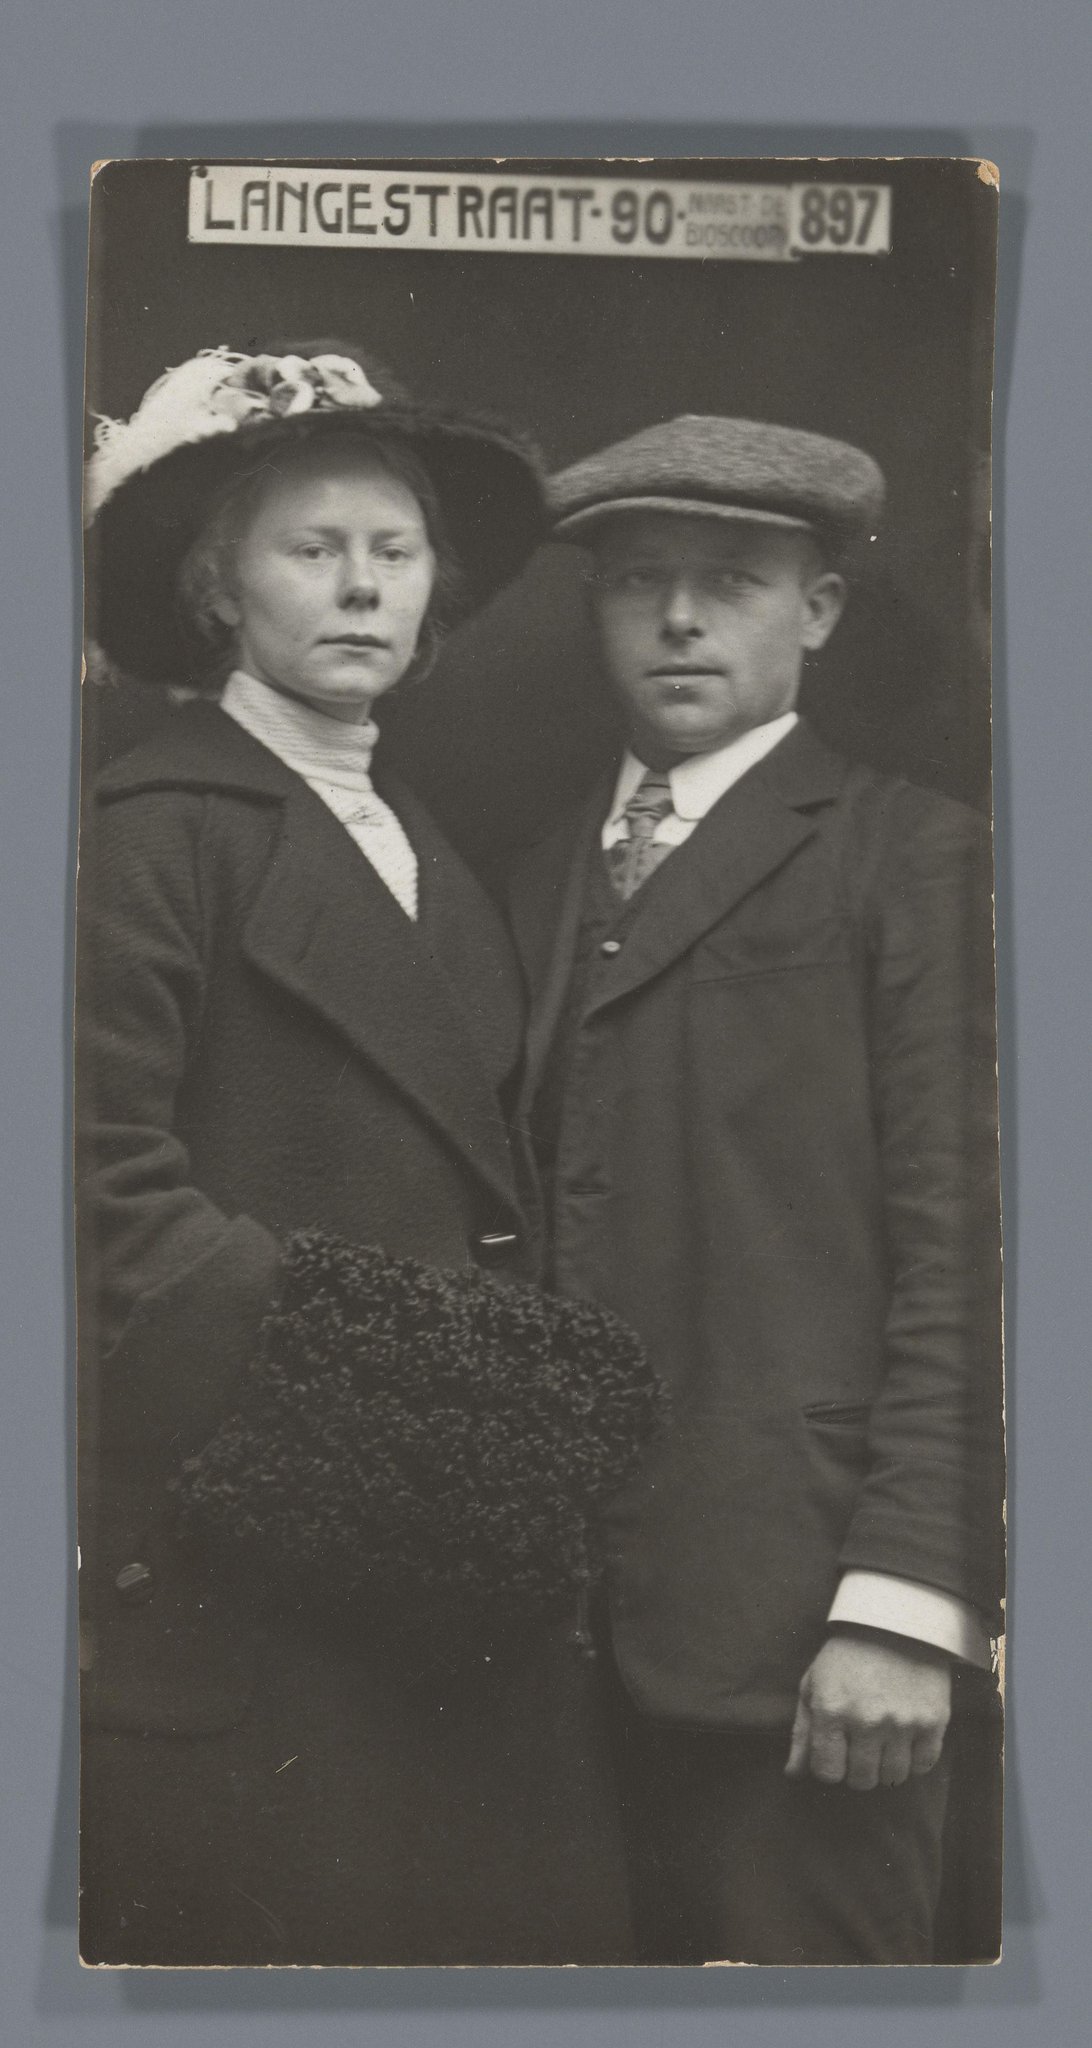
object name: snapshot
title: Rapid photographs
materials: photographic support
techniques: gelatin silver print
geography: alkmaar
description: Between 1912 and 1930, anyone could have their portrait taken at the many so-called rapid photography studios in the shopping streets of mainly (medium) large-size European cities. As if on an assembly line, the youngest clerk shot the photographs with a special camera and in artificial light and developed them. Later in the day, the customer collected a sheet with 12 portrait photos for 25 cents. This form of photographic mass production gave rise to a fascinating tableau of boys, girls, men and women not previously seen in photographs; candid and informal. There were at least 150 quick-photo studios, from Alkmaar to Zutphen. Many called themselves ‘American,’ mistakenly as it turns out because hardly any examples from that country have been found.